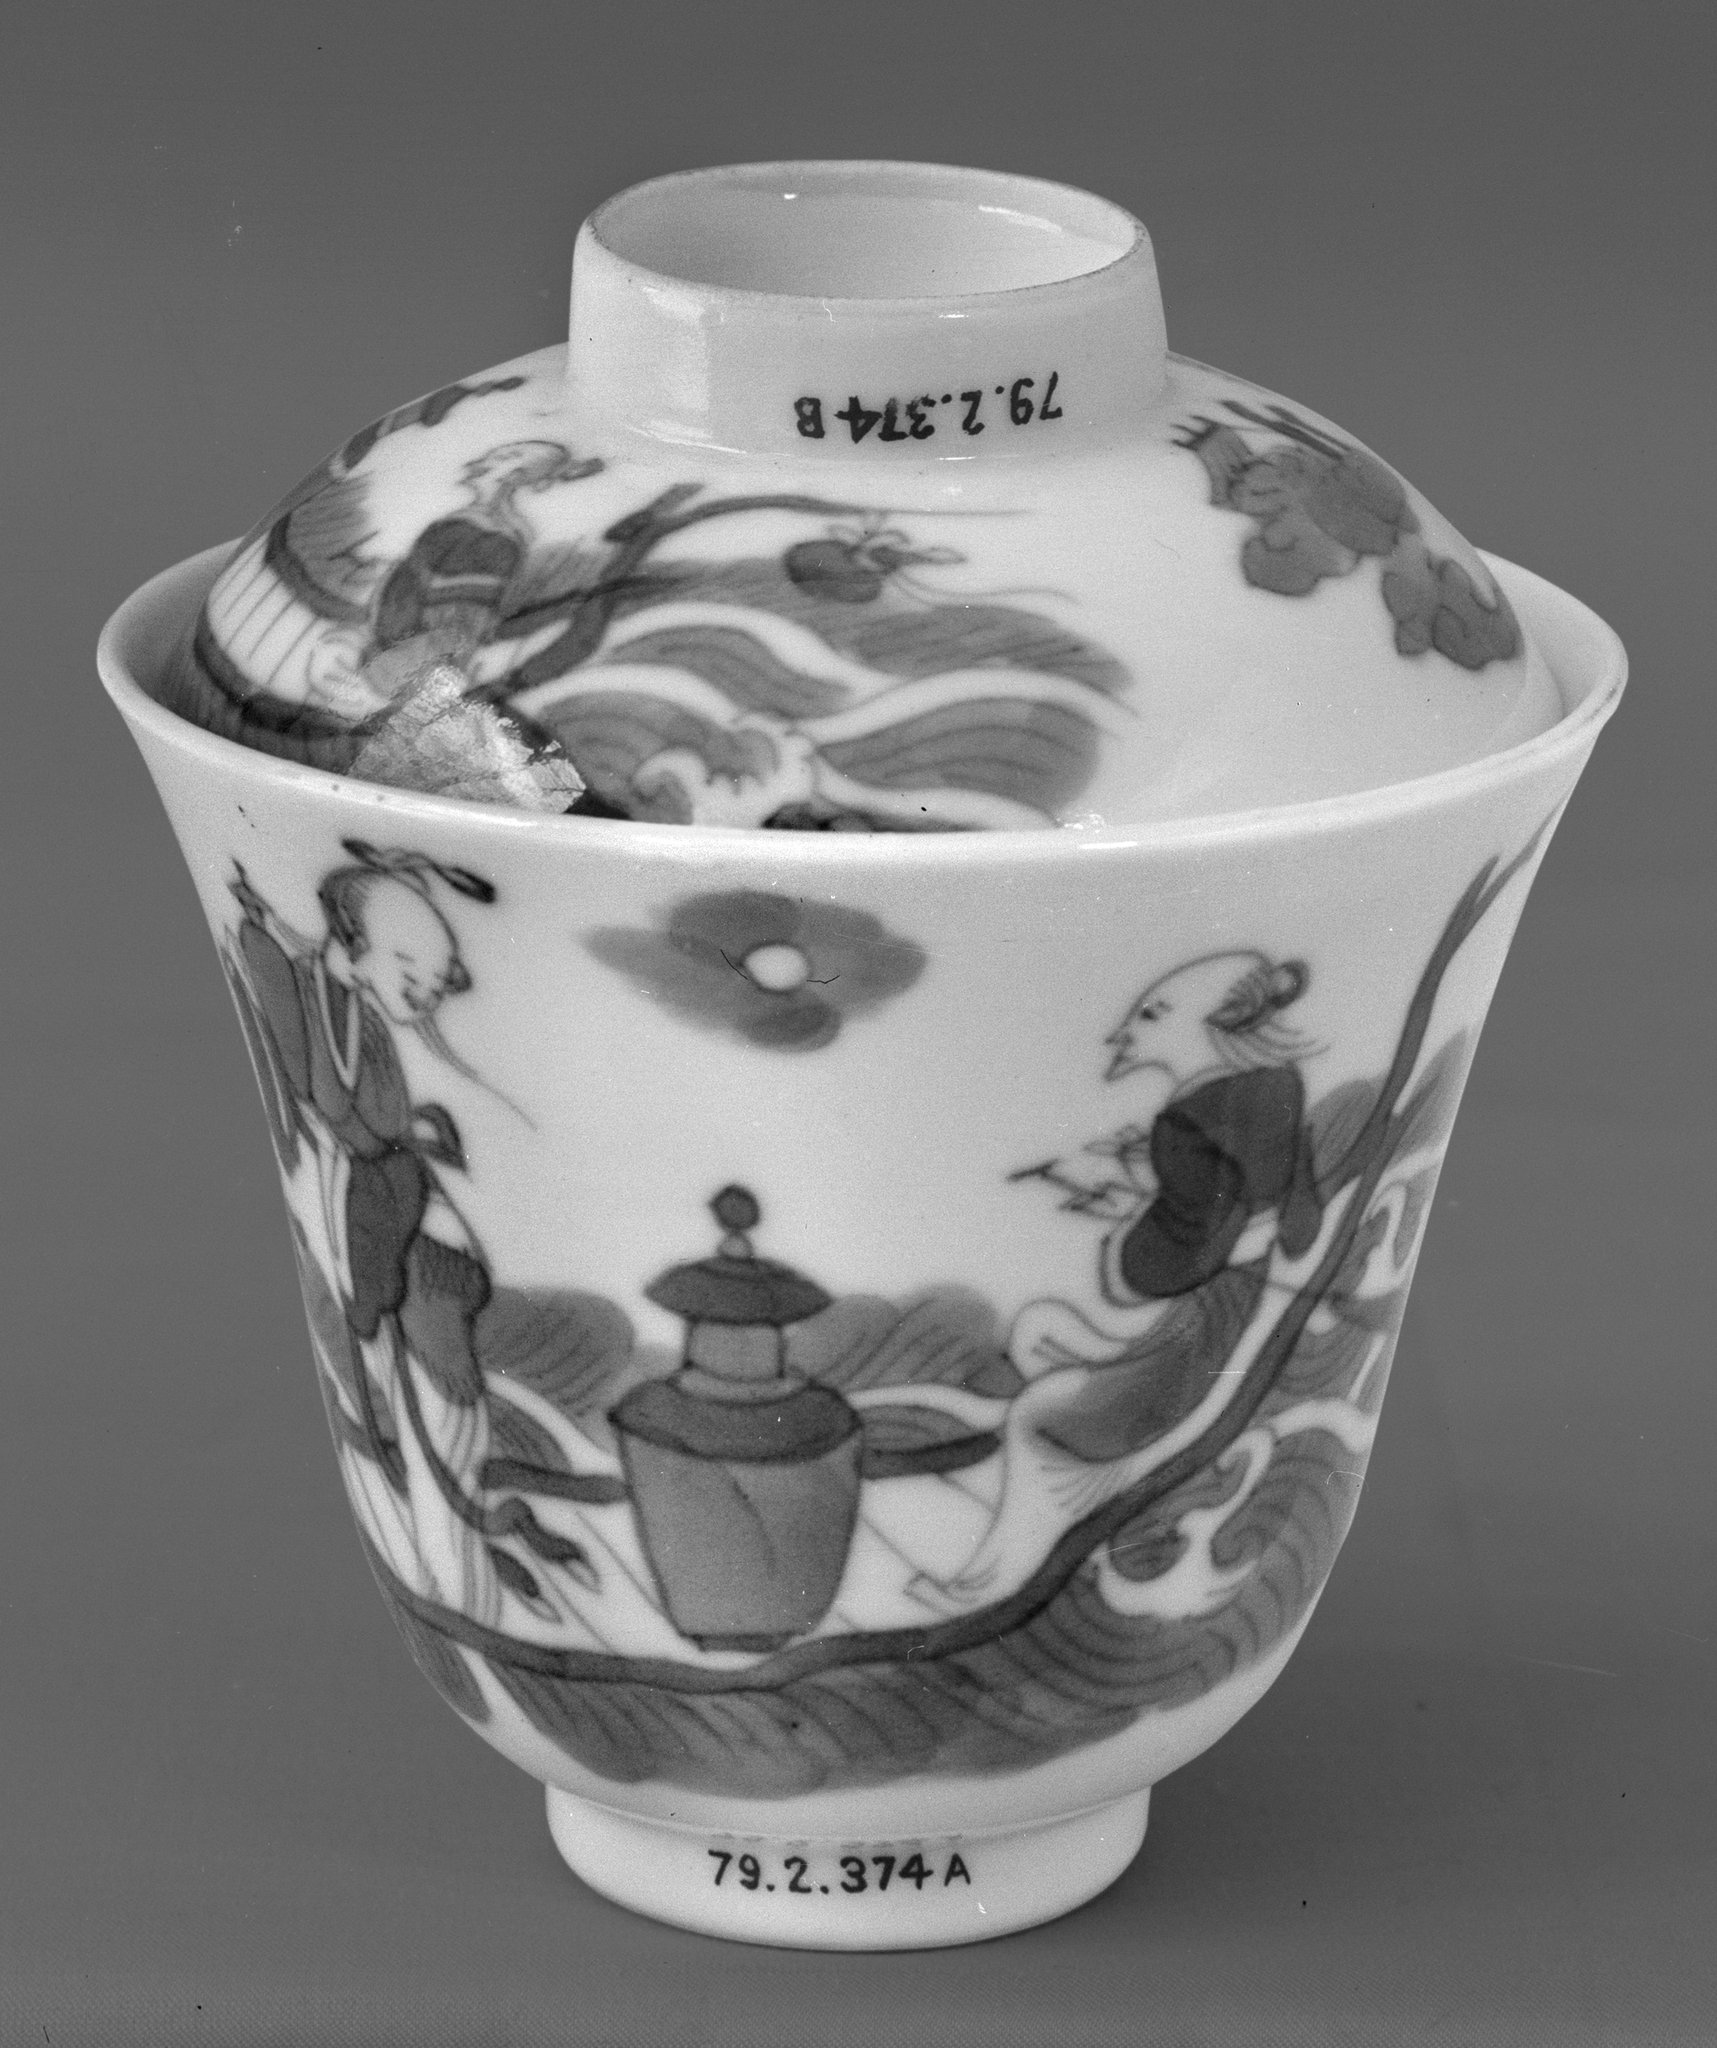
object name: covered cup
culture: chinese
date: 1821-1850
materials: porcelain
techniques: painting, underglaze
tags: human figures